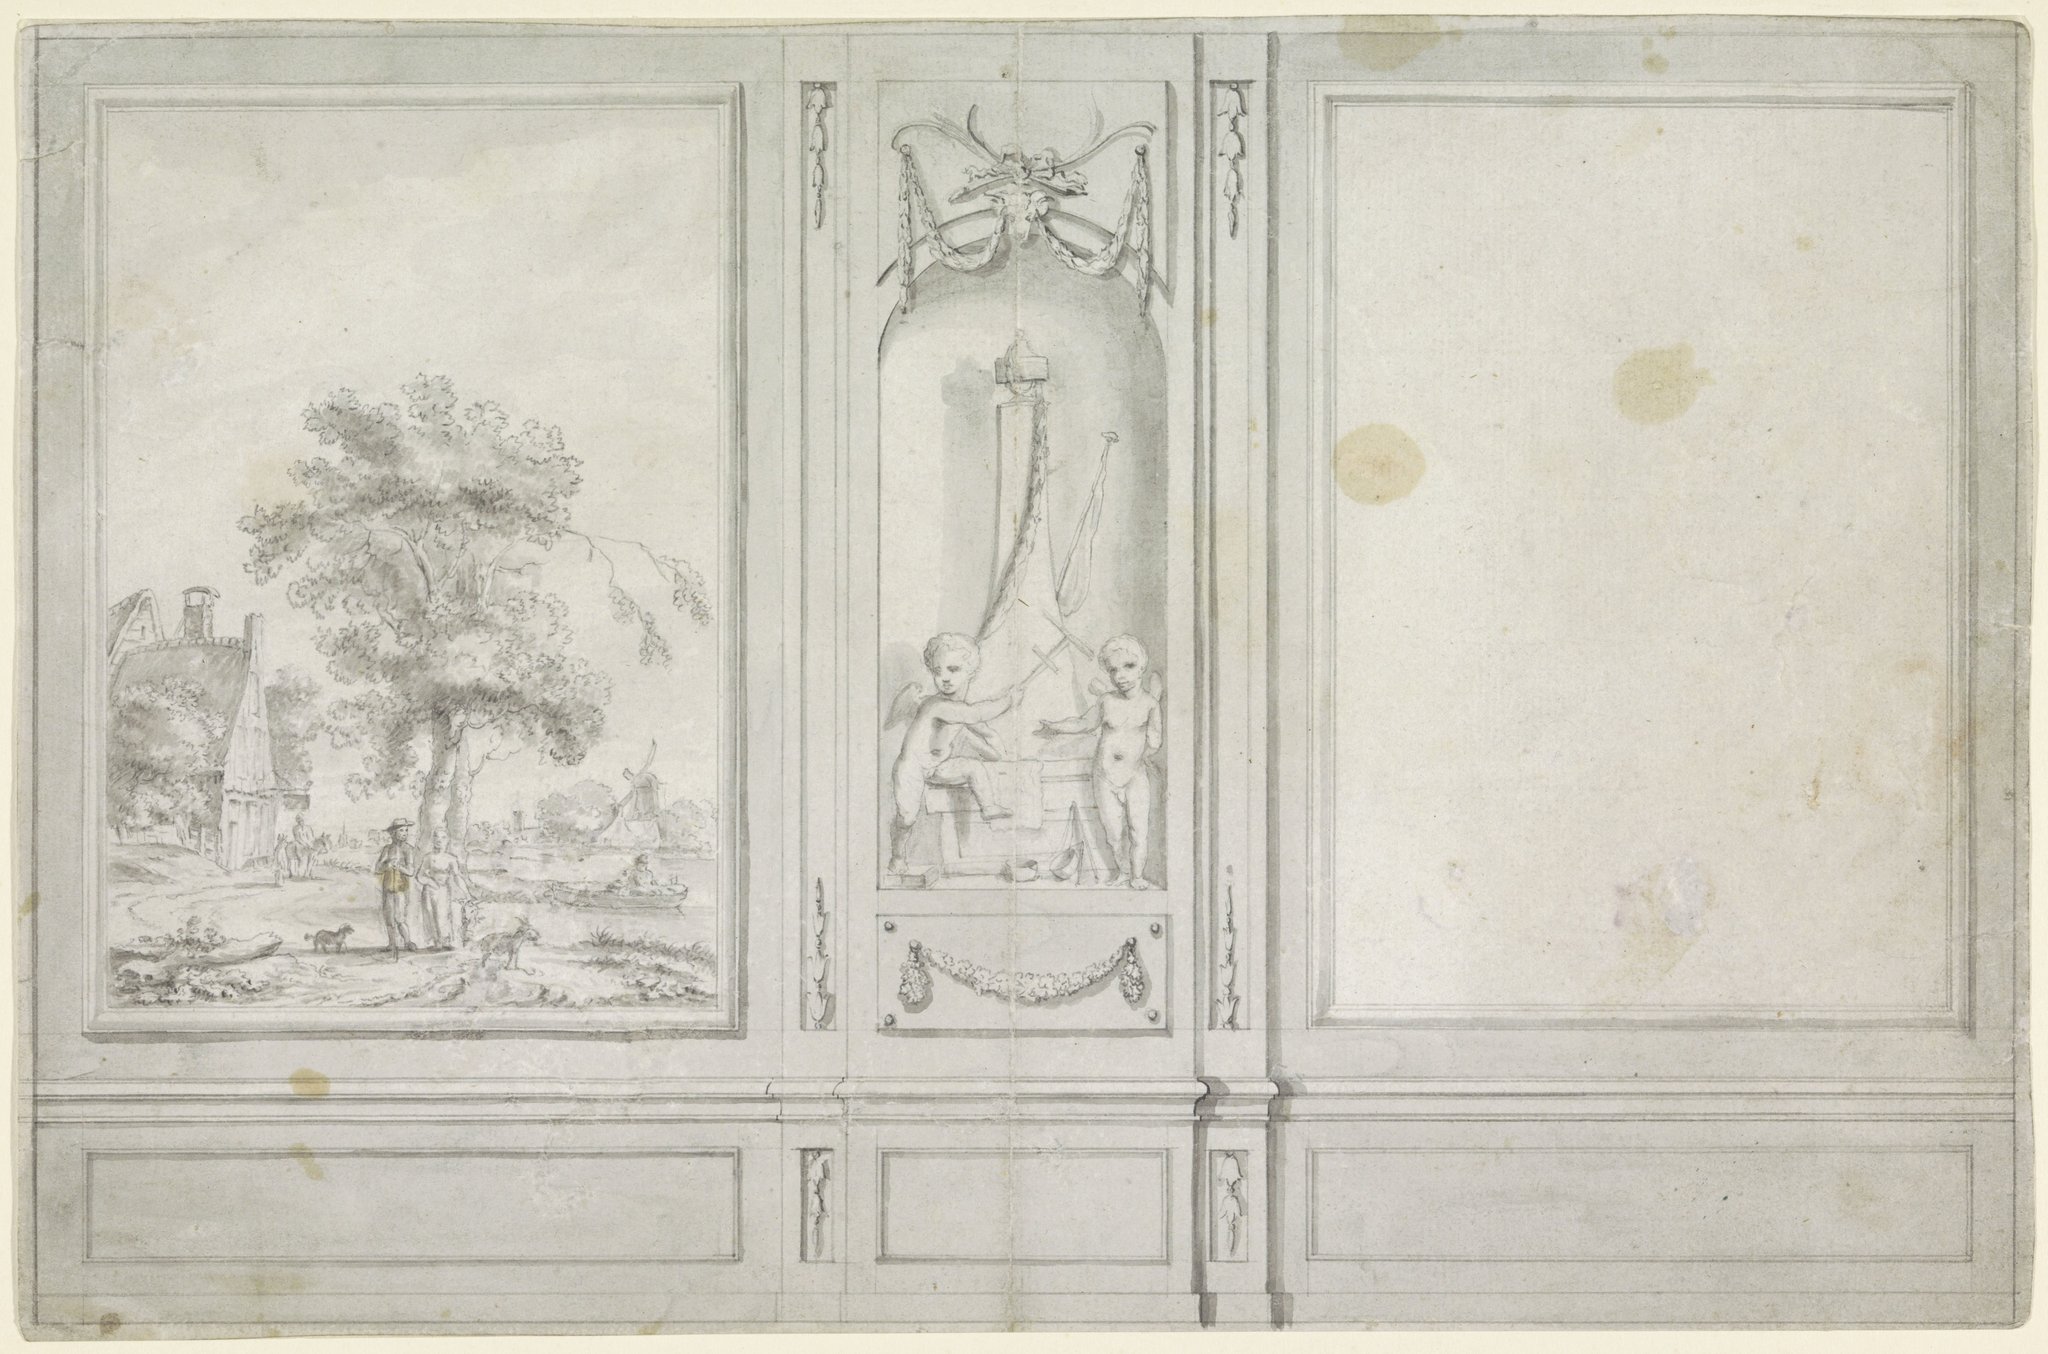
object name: drawing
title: Panelen en nis met putti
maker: Anonymous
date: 1650-1800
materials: ink, paper, pencil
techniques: brush, pen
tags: panelling, 'concha' ~ architecture, pastorals, arcadian scenes, cupids: 'amores', 'amoretti', 'putti'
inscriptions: collector's mark: Lugt 2228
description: In het midden een halfronde nis met een obelisk en twee putti. Aan weerszijden panelen. Links met een pastorale scène met figuren in een landschap met een huis, een boom, een man in een boot en een molen.